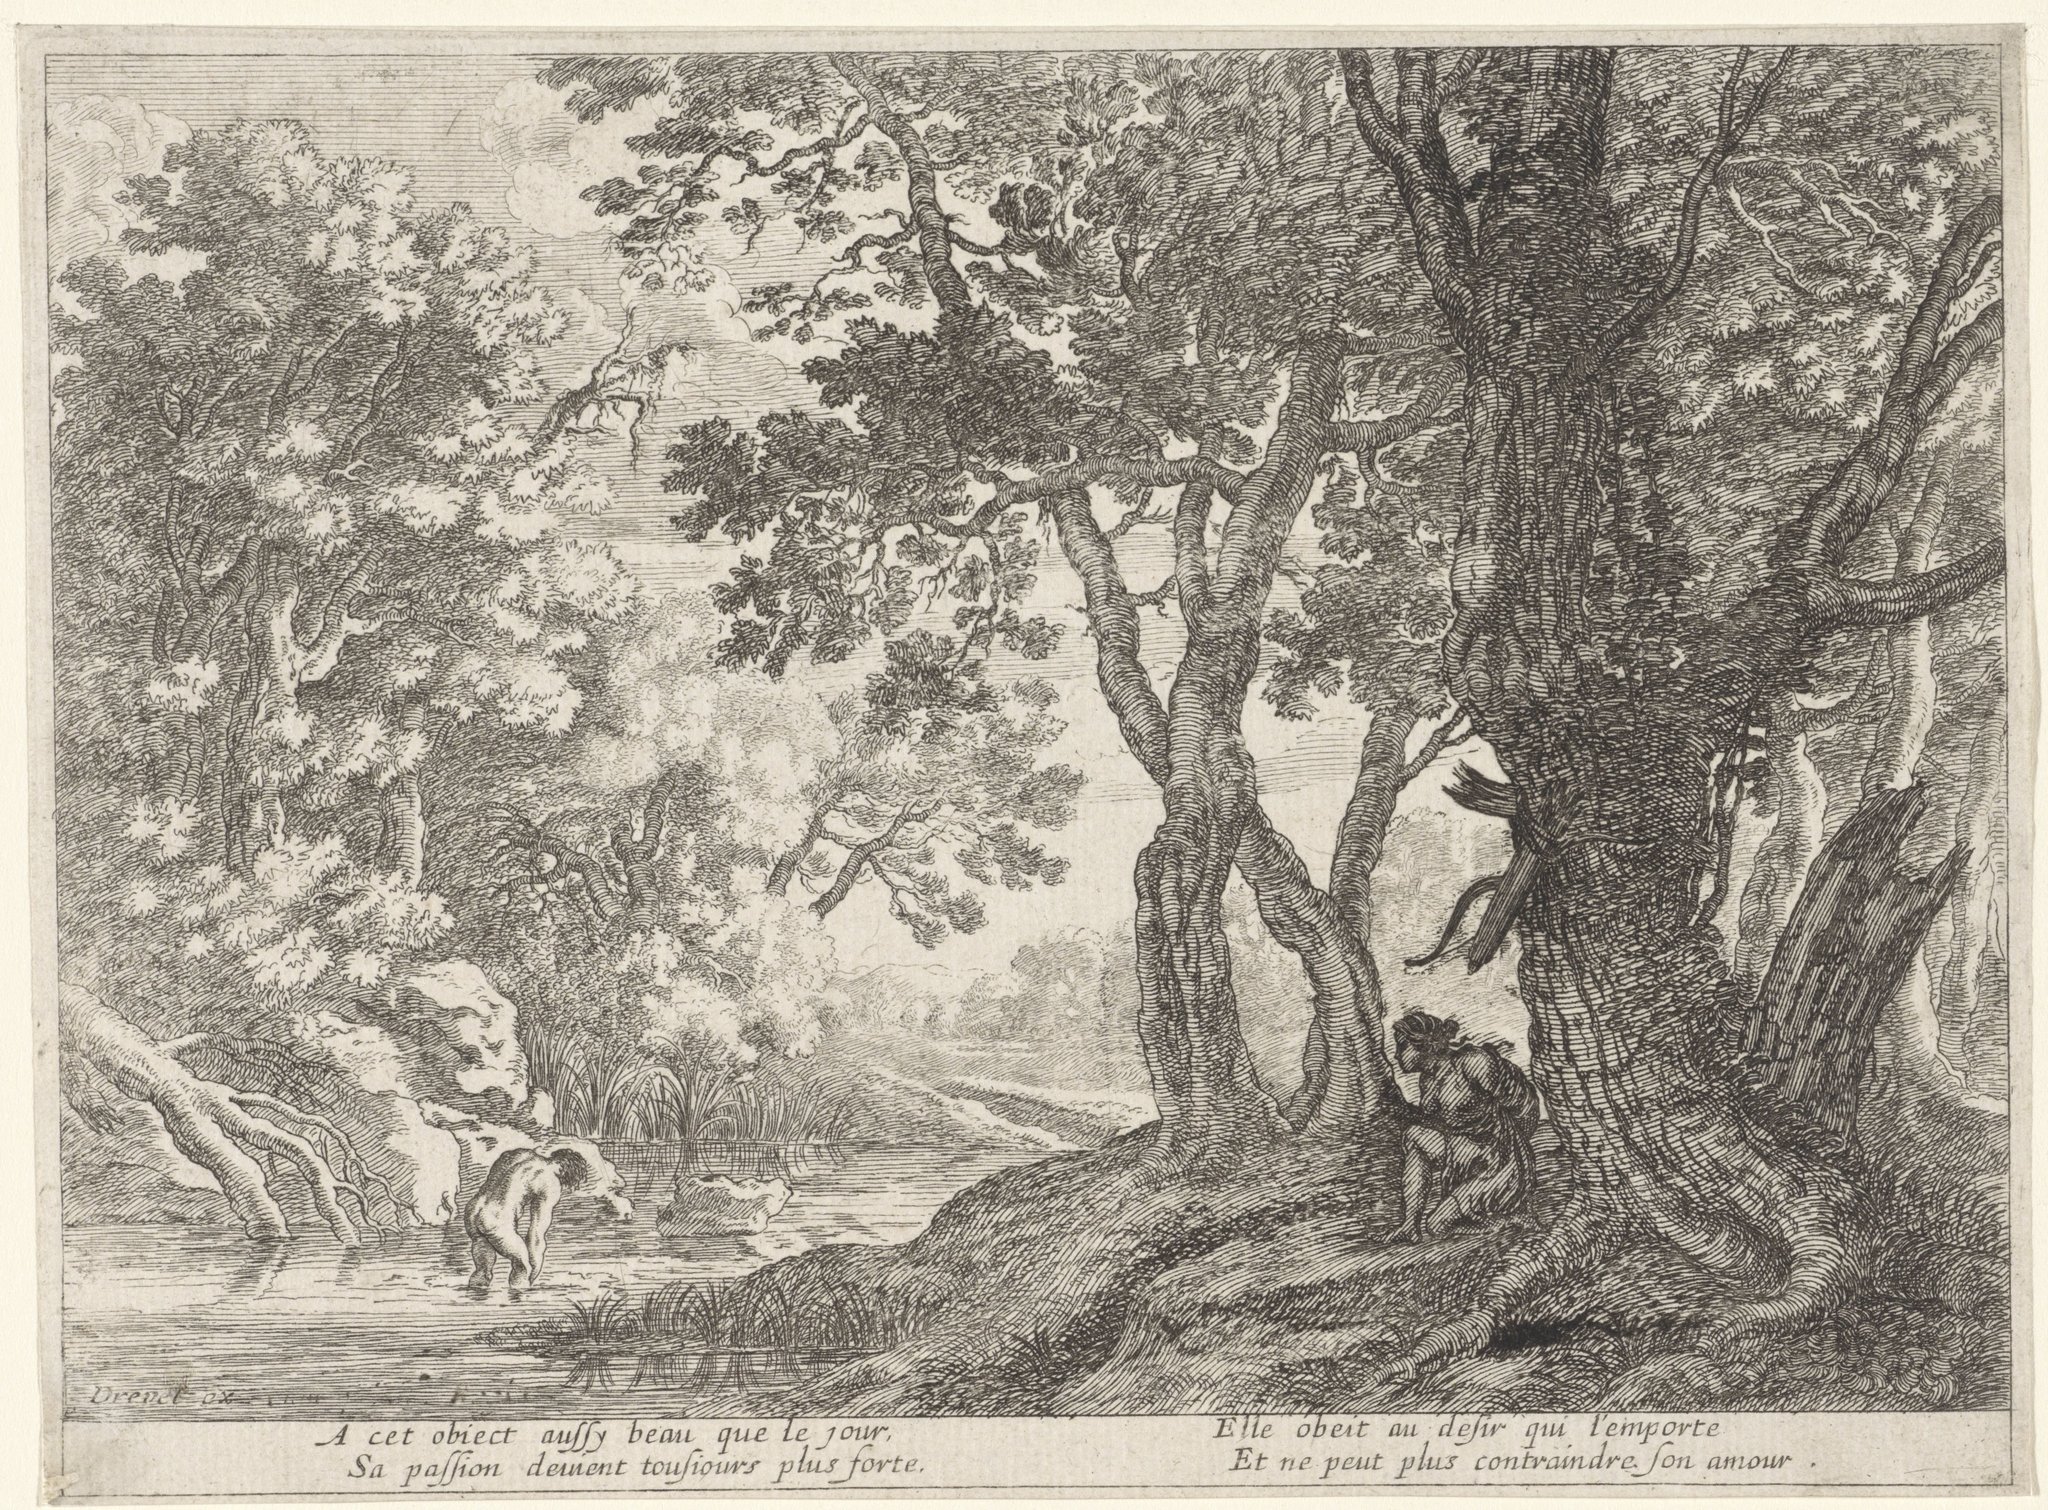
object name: print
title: Salmacis en Hermaphrodite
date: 1663-1738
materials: paper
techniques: etching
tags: when hermaphroditus bathes in a fountain, salmacis, the nymph of the fountain, falls in love with him, hermaphroditus and salmacis changed into a hermaphrodite: at the prayer of the fountain-nymph salmacis, who holds the bathing hermaphroditus closely embraced, their bodies fuse (ovid, metamorphoses iv 373)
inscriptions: collector's mark: Lugt 2228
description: Salmacis zit onder een boom, terwijl Hermaphroditus in het water baadt. Onder de voorstelling bevindt zich een vierregelig, Frans gedicht.